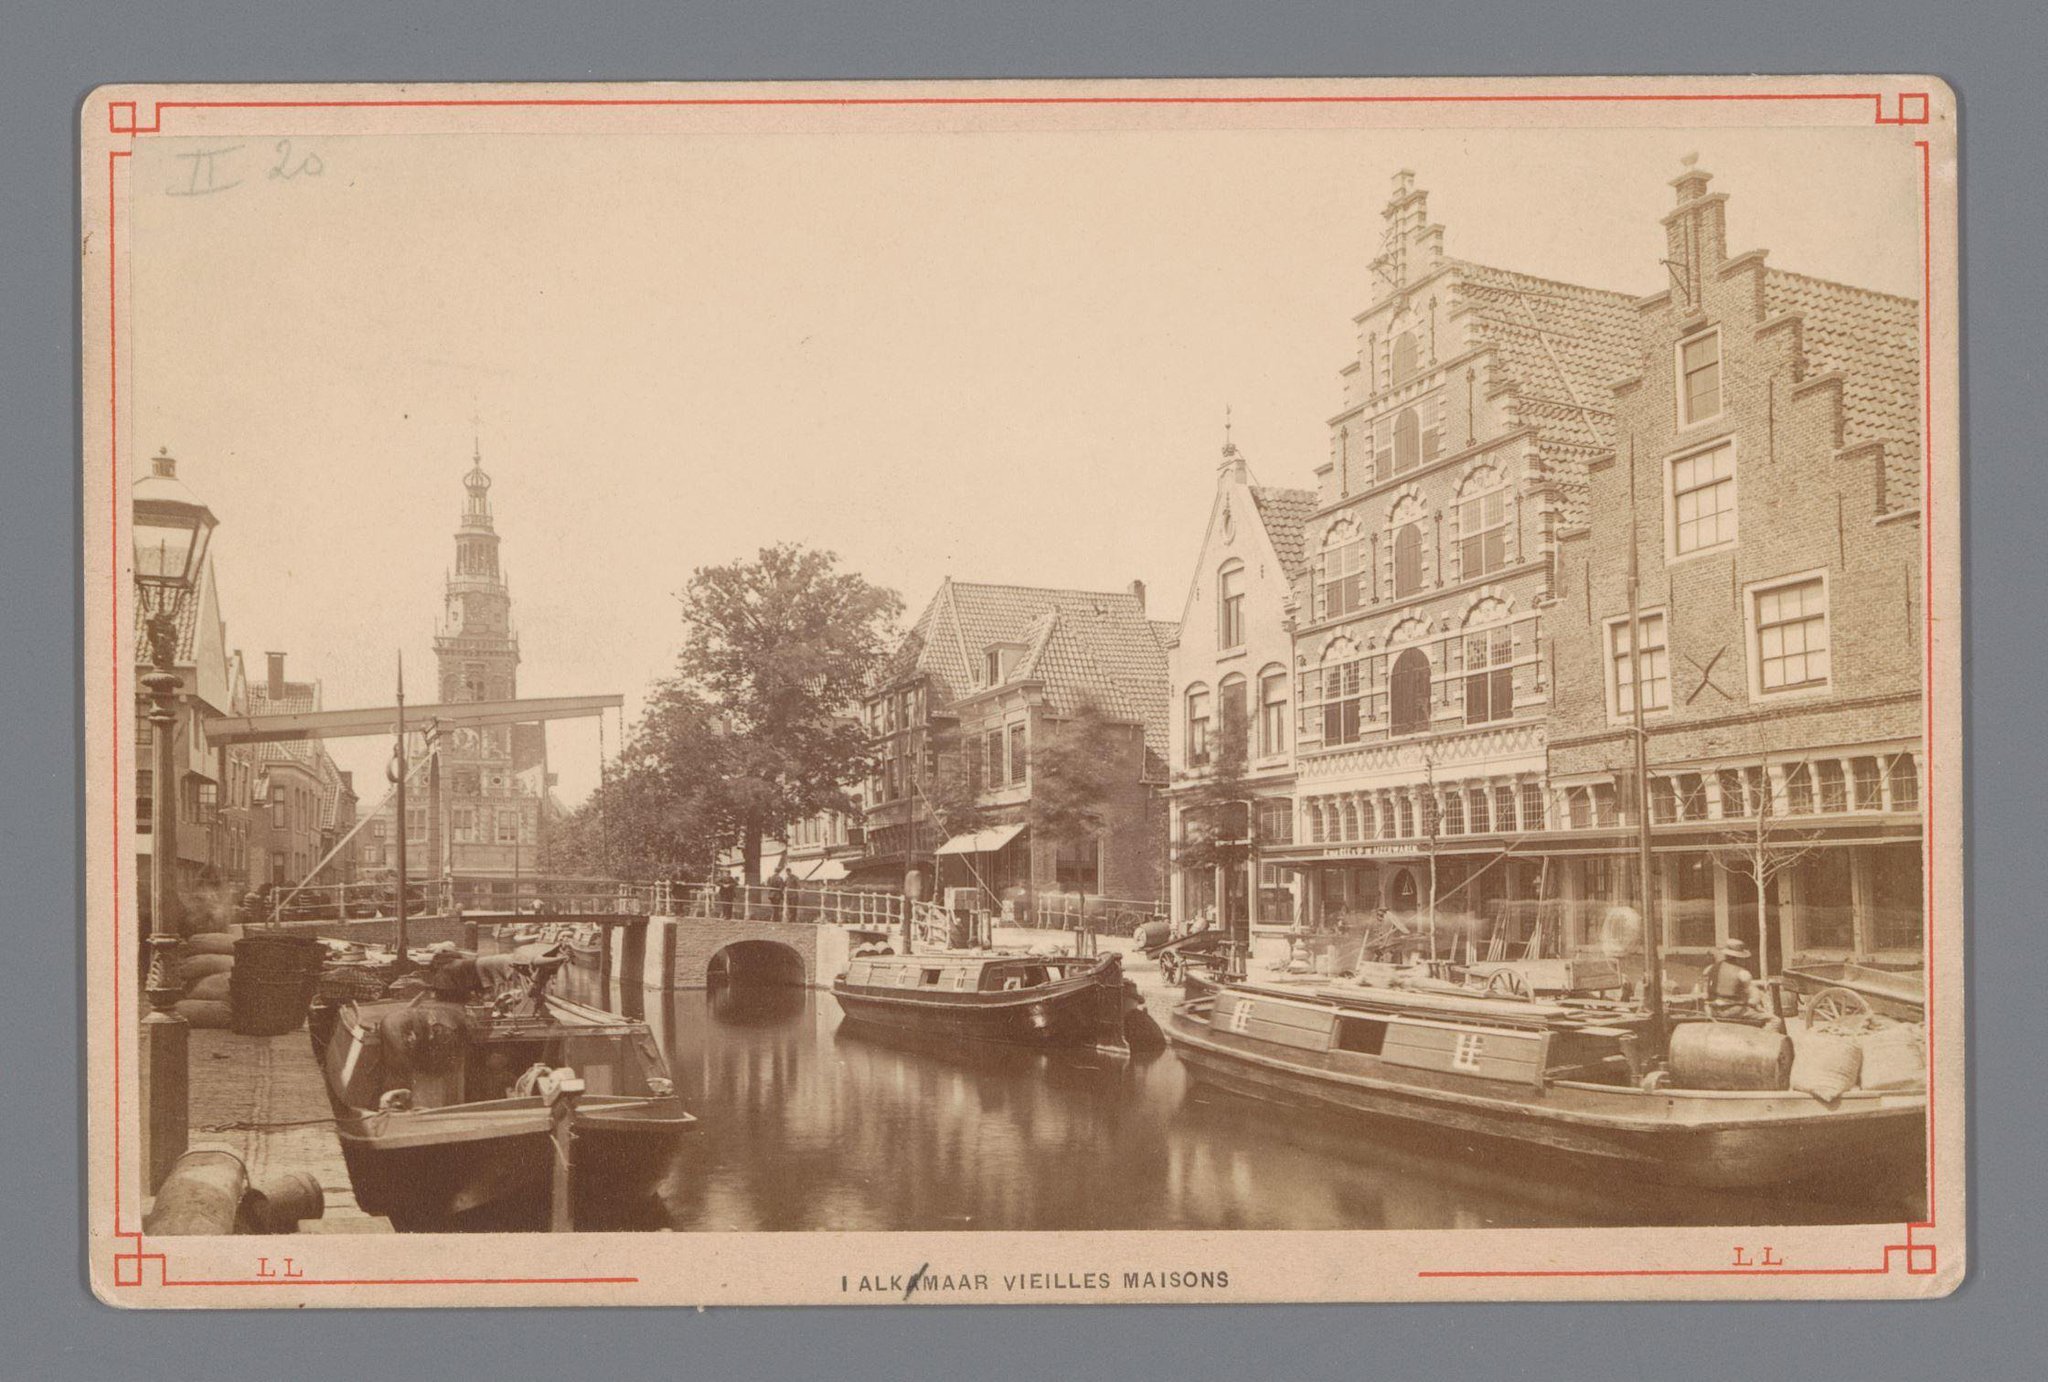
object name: photograph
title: Straatgezicht te Alkmaar met De Waag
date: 1870-1900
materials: cardboard, photographic support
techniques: albumen print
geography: alkmaar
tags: city-view in general; 'veduta', street (+ city(-scape) with figures, staffage)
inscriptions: inscription: ‘LL/ I Alkamaar Vieilles Maisons/ LL’, number: ‘II 20’, annotation: ‘III/2/ 50ct/ k/ [Swaten]’